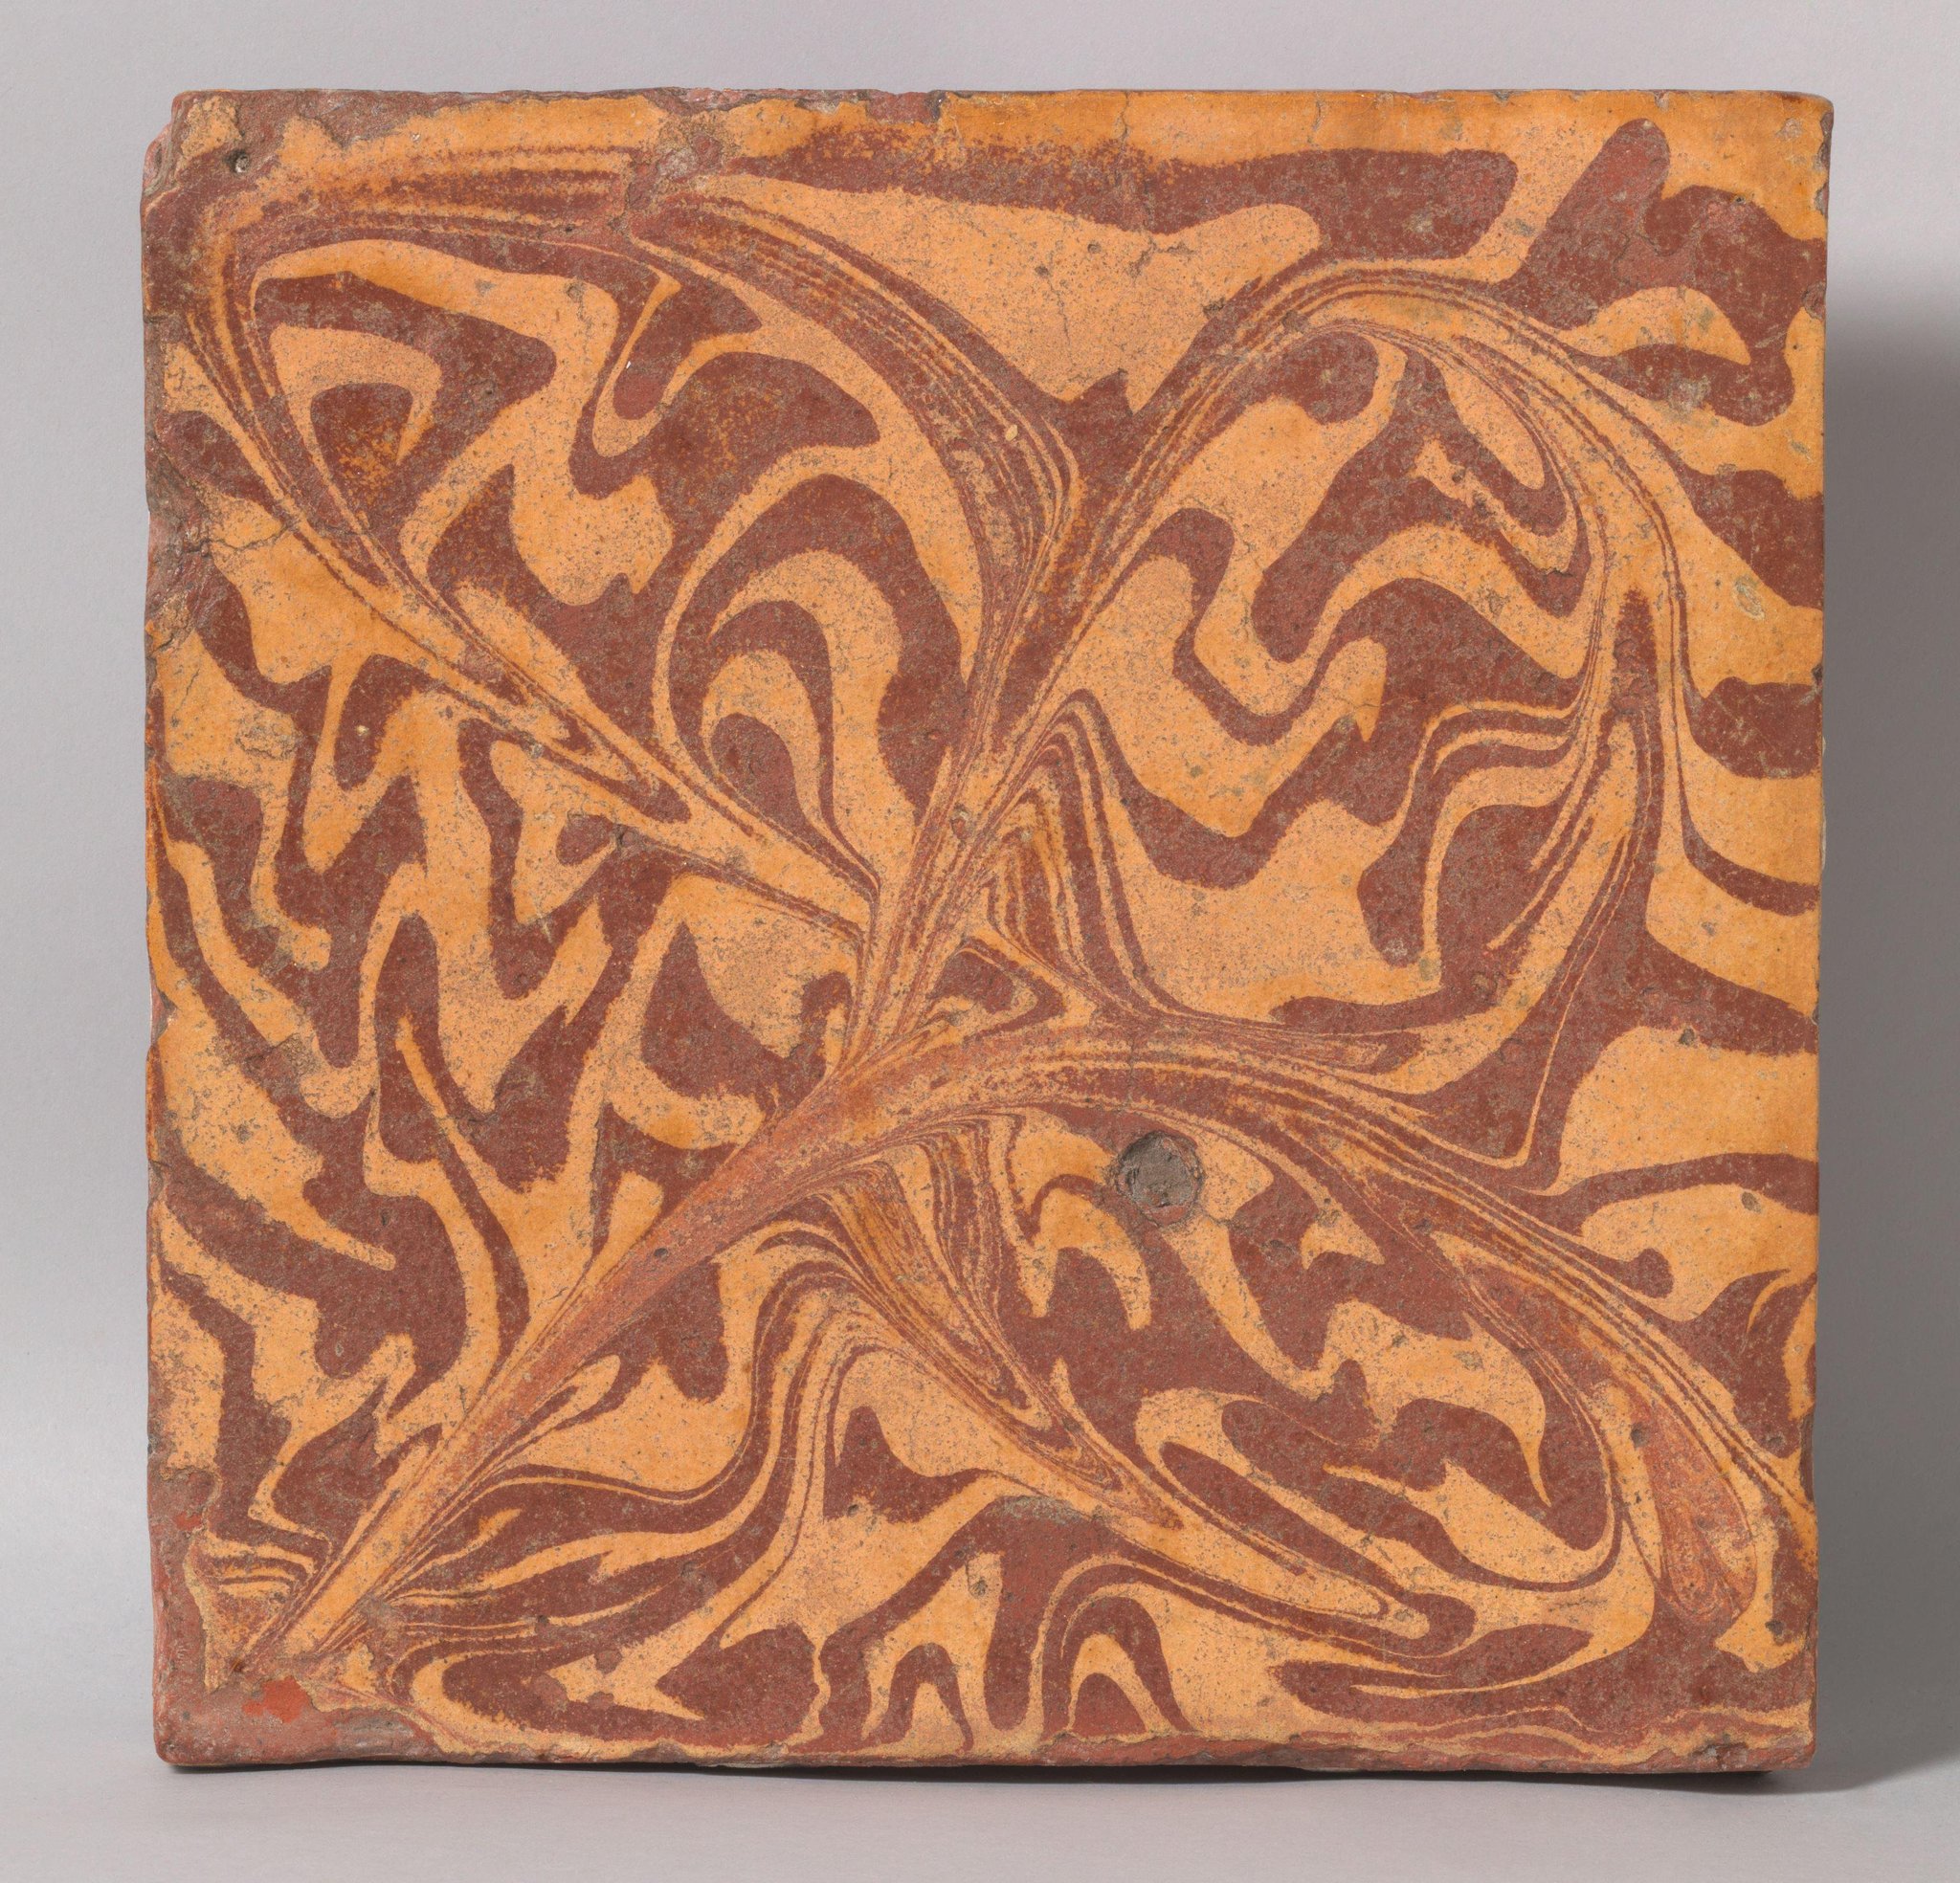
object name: architectural element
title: Vloertegel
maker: Anonymous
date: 1600-1650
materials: earthenware, glaze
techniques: slip technique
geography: netherlands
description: Vloertegel met een bladmotief in een marmerversiering.